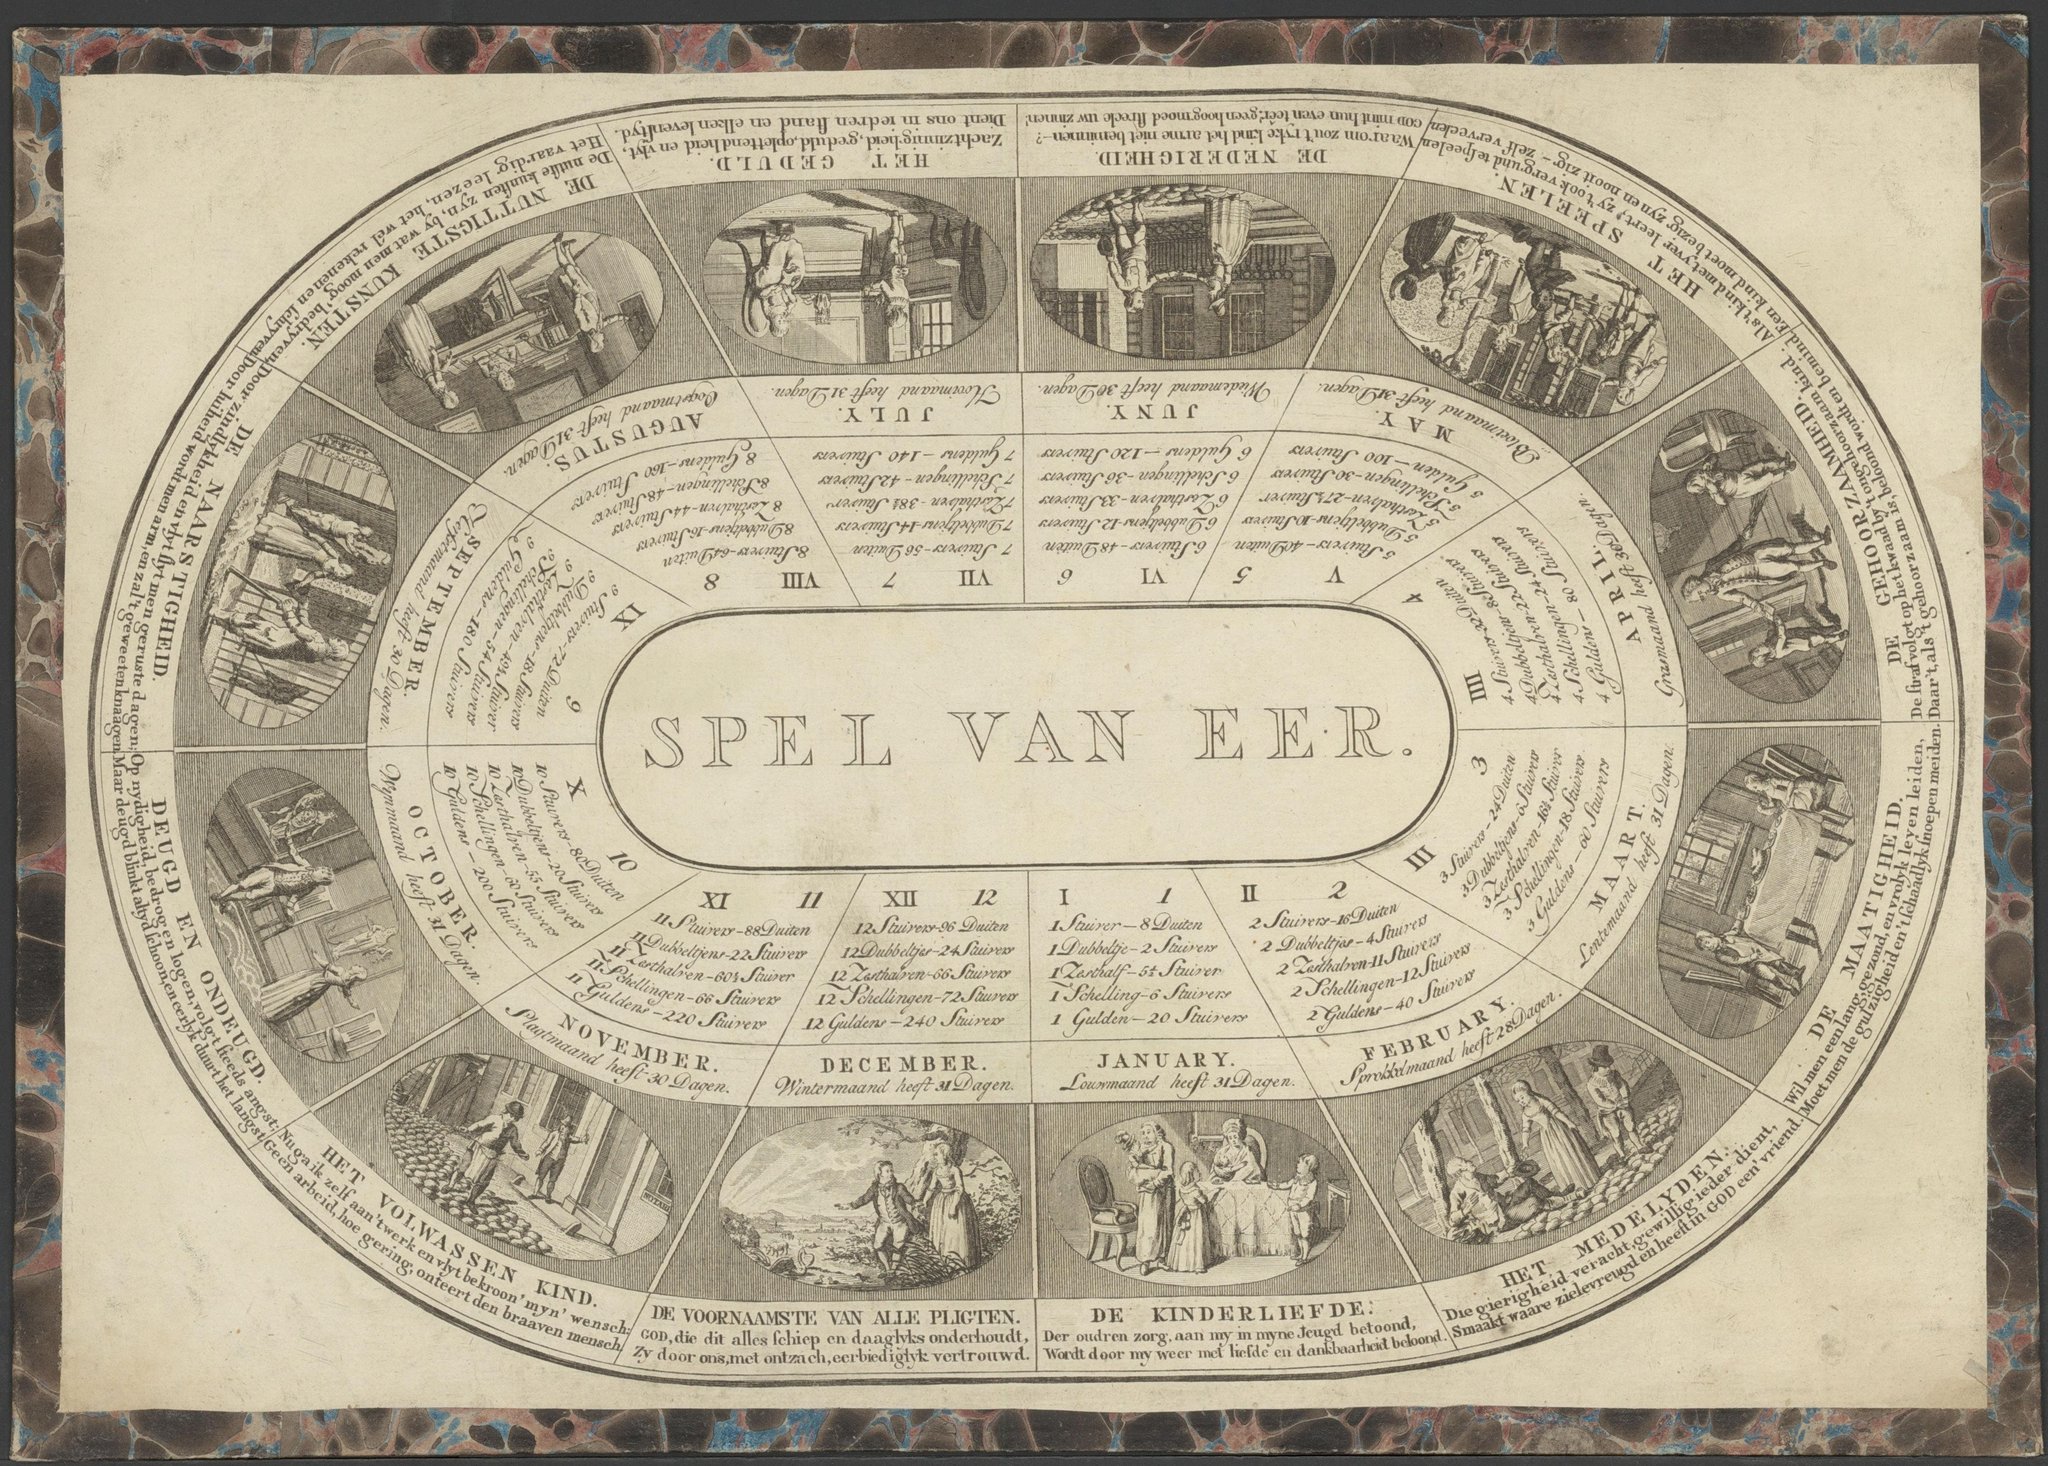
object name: gameboard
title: Spel van Eer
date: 1798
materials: cardboard, paper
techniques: etching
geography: amsterdam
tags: board-games of chance, the twelve months represented by scenes showing human activities, usually in a landscape; so-called 'labours of the months'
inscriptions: collector's mark: Lugt 1641, collector's mark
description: Ovaal bordspel met de titel in het midden, verdeeld in twaalf vakken met de maanden van het jaar. Bij elke maand een scène, voornamelijk uit het kinderleven, waarin een deugd wordt afgebeeld, die in het onderschrift wordt genoemd en wordt verduidelijkt in een tweeregelig vers. Bij de prent behoort een afzonderlijk boekje met de spelregels. Onderwerpsrubrieken binnen de Atlas Zeden en Gewoonten: Spel en Vermaak; gezelschapsspel, ganzenbord en dergelijke.